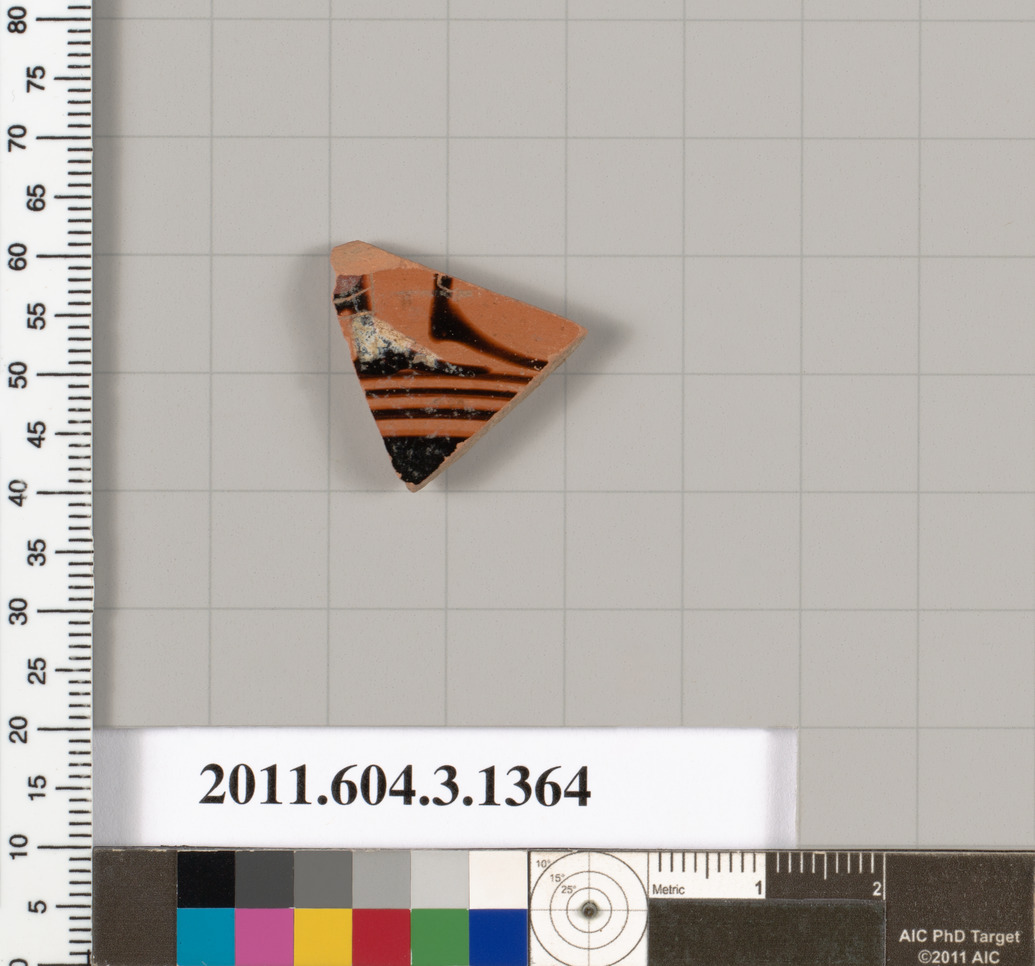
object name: skyphos fragment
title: Terracotta fragment of a skyphos (deep drinking cup)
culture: greek, attic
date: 500-468 BCE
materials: terracotta